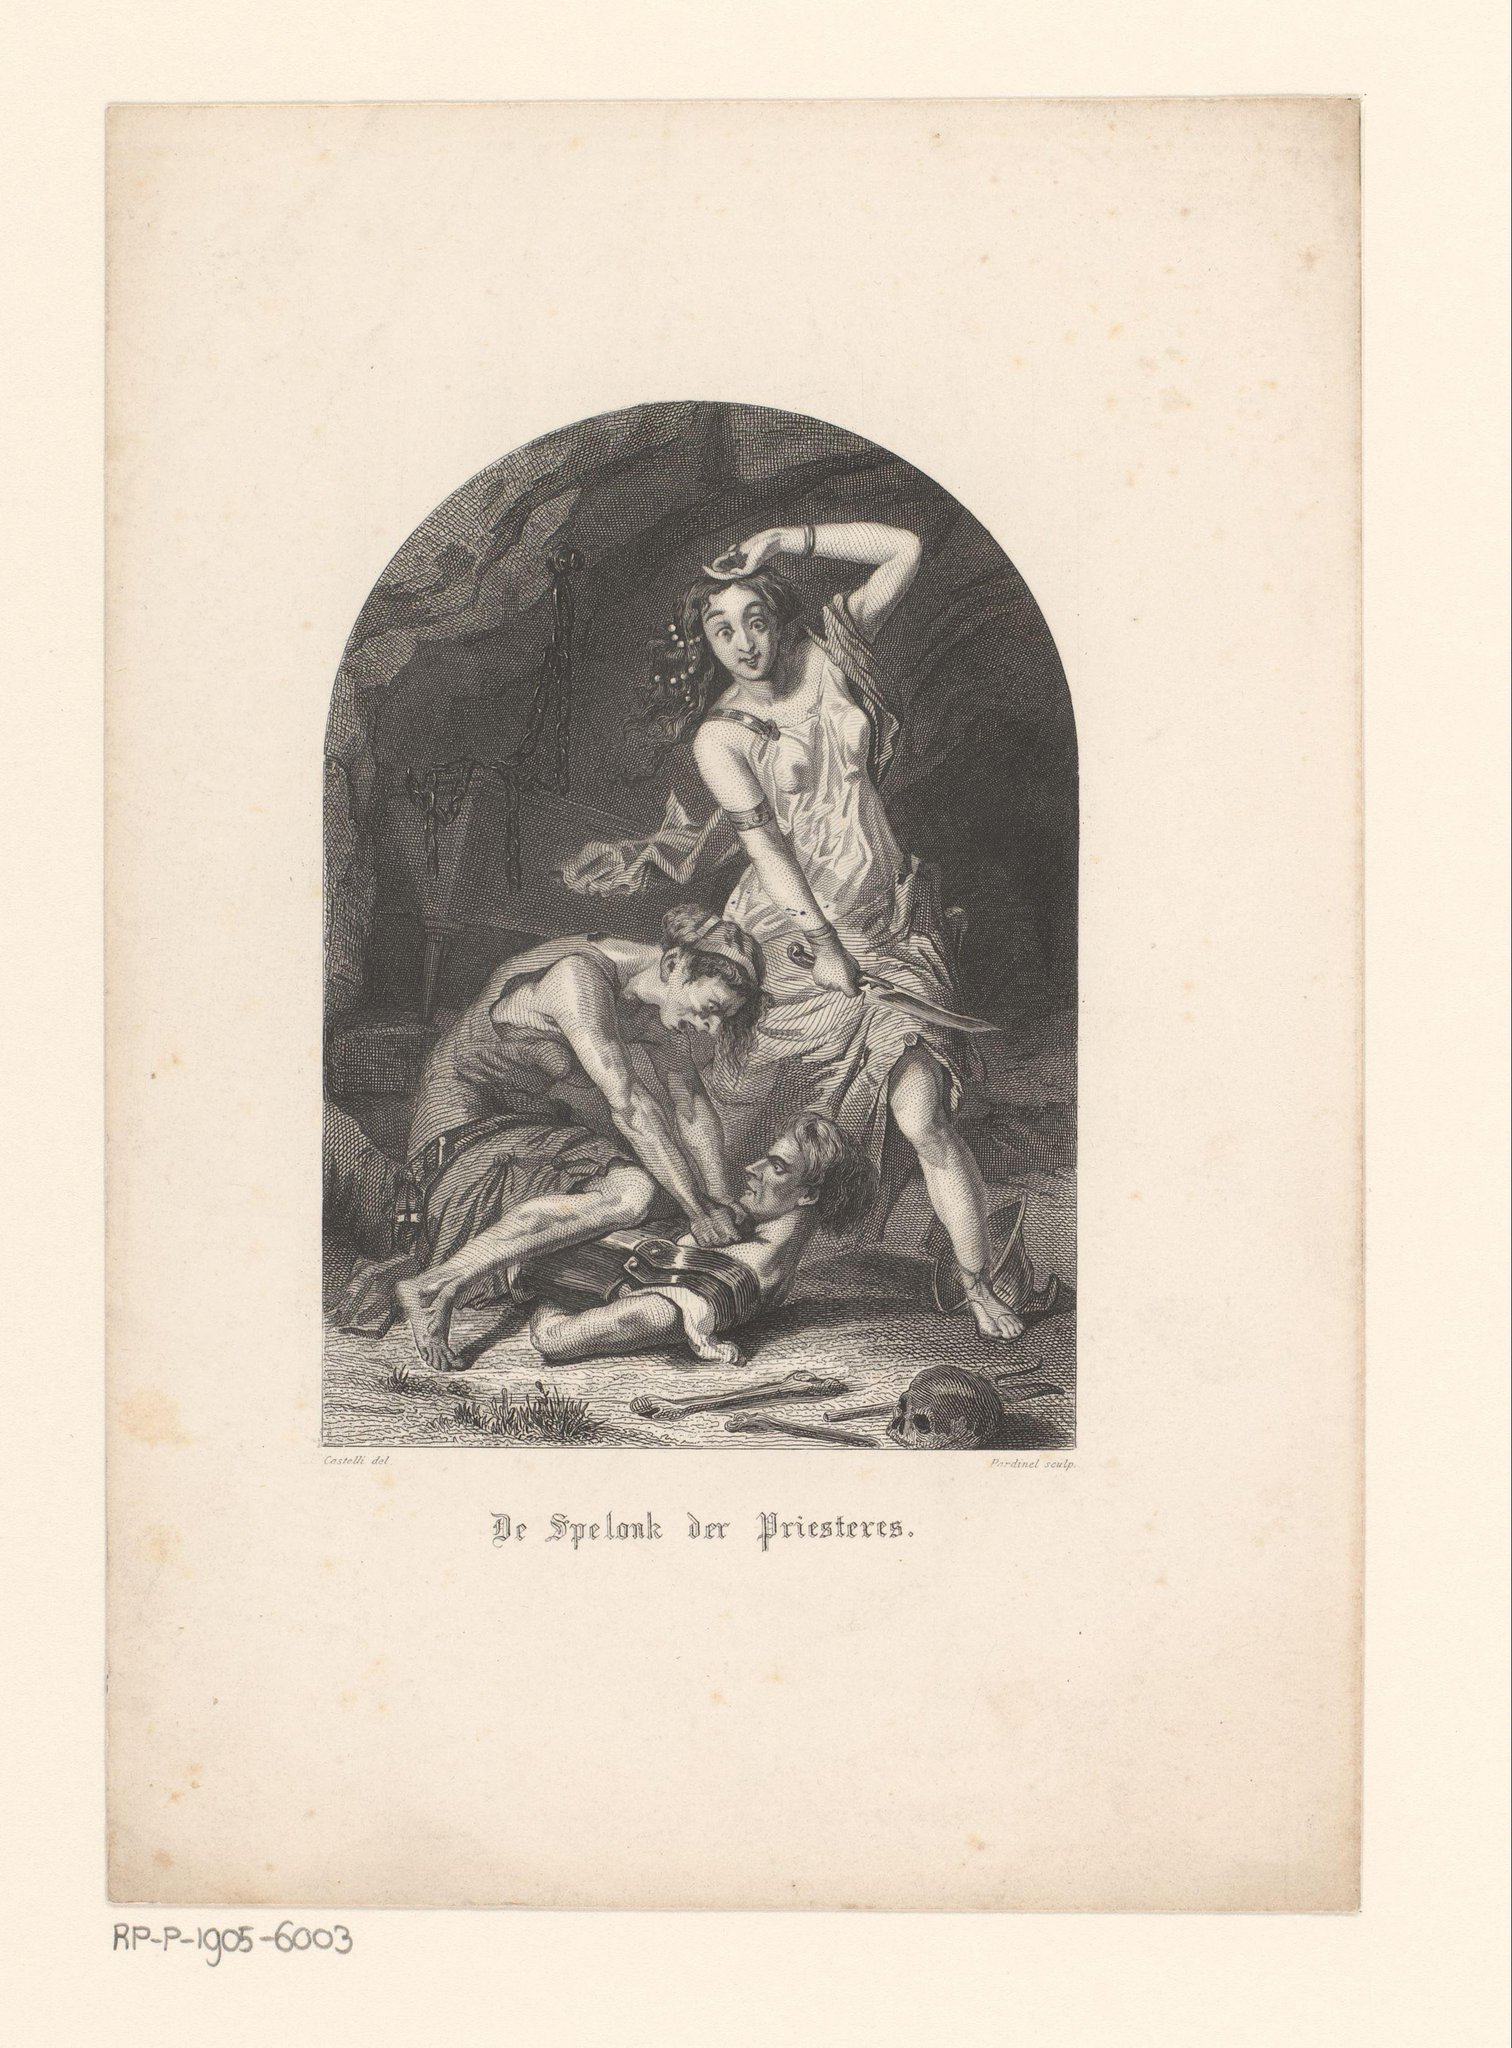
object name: print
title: Twee vrouwen vallen een man aan in een grot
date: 1818-1905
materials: paper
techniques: etching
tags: priestess ~ roman religion, cave, grotto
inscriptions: collector's mark: Lugt 2228